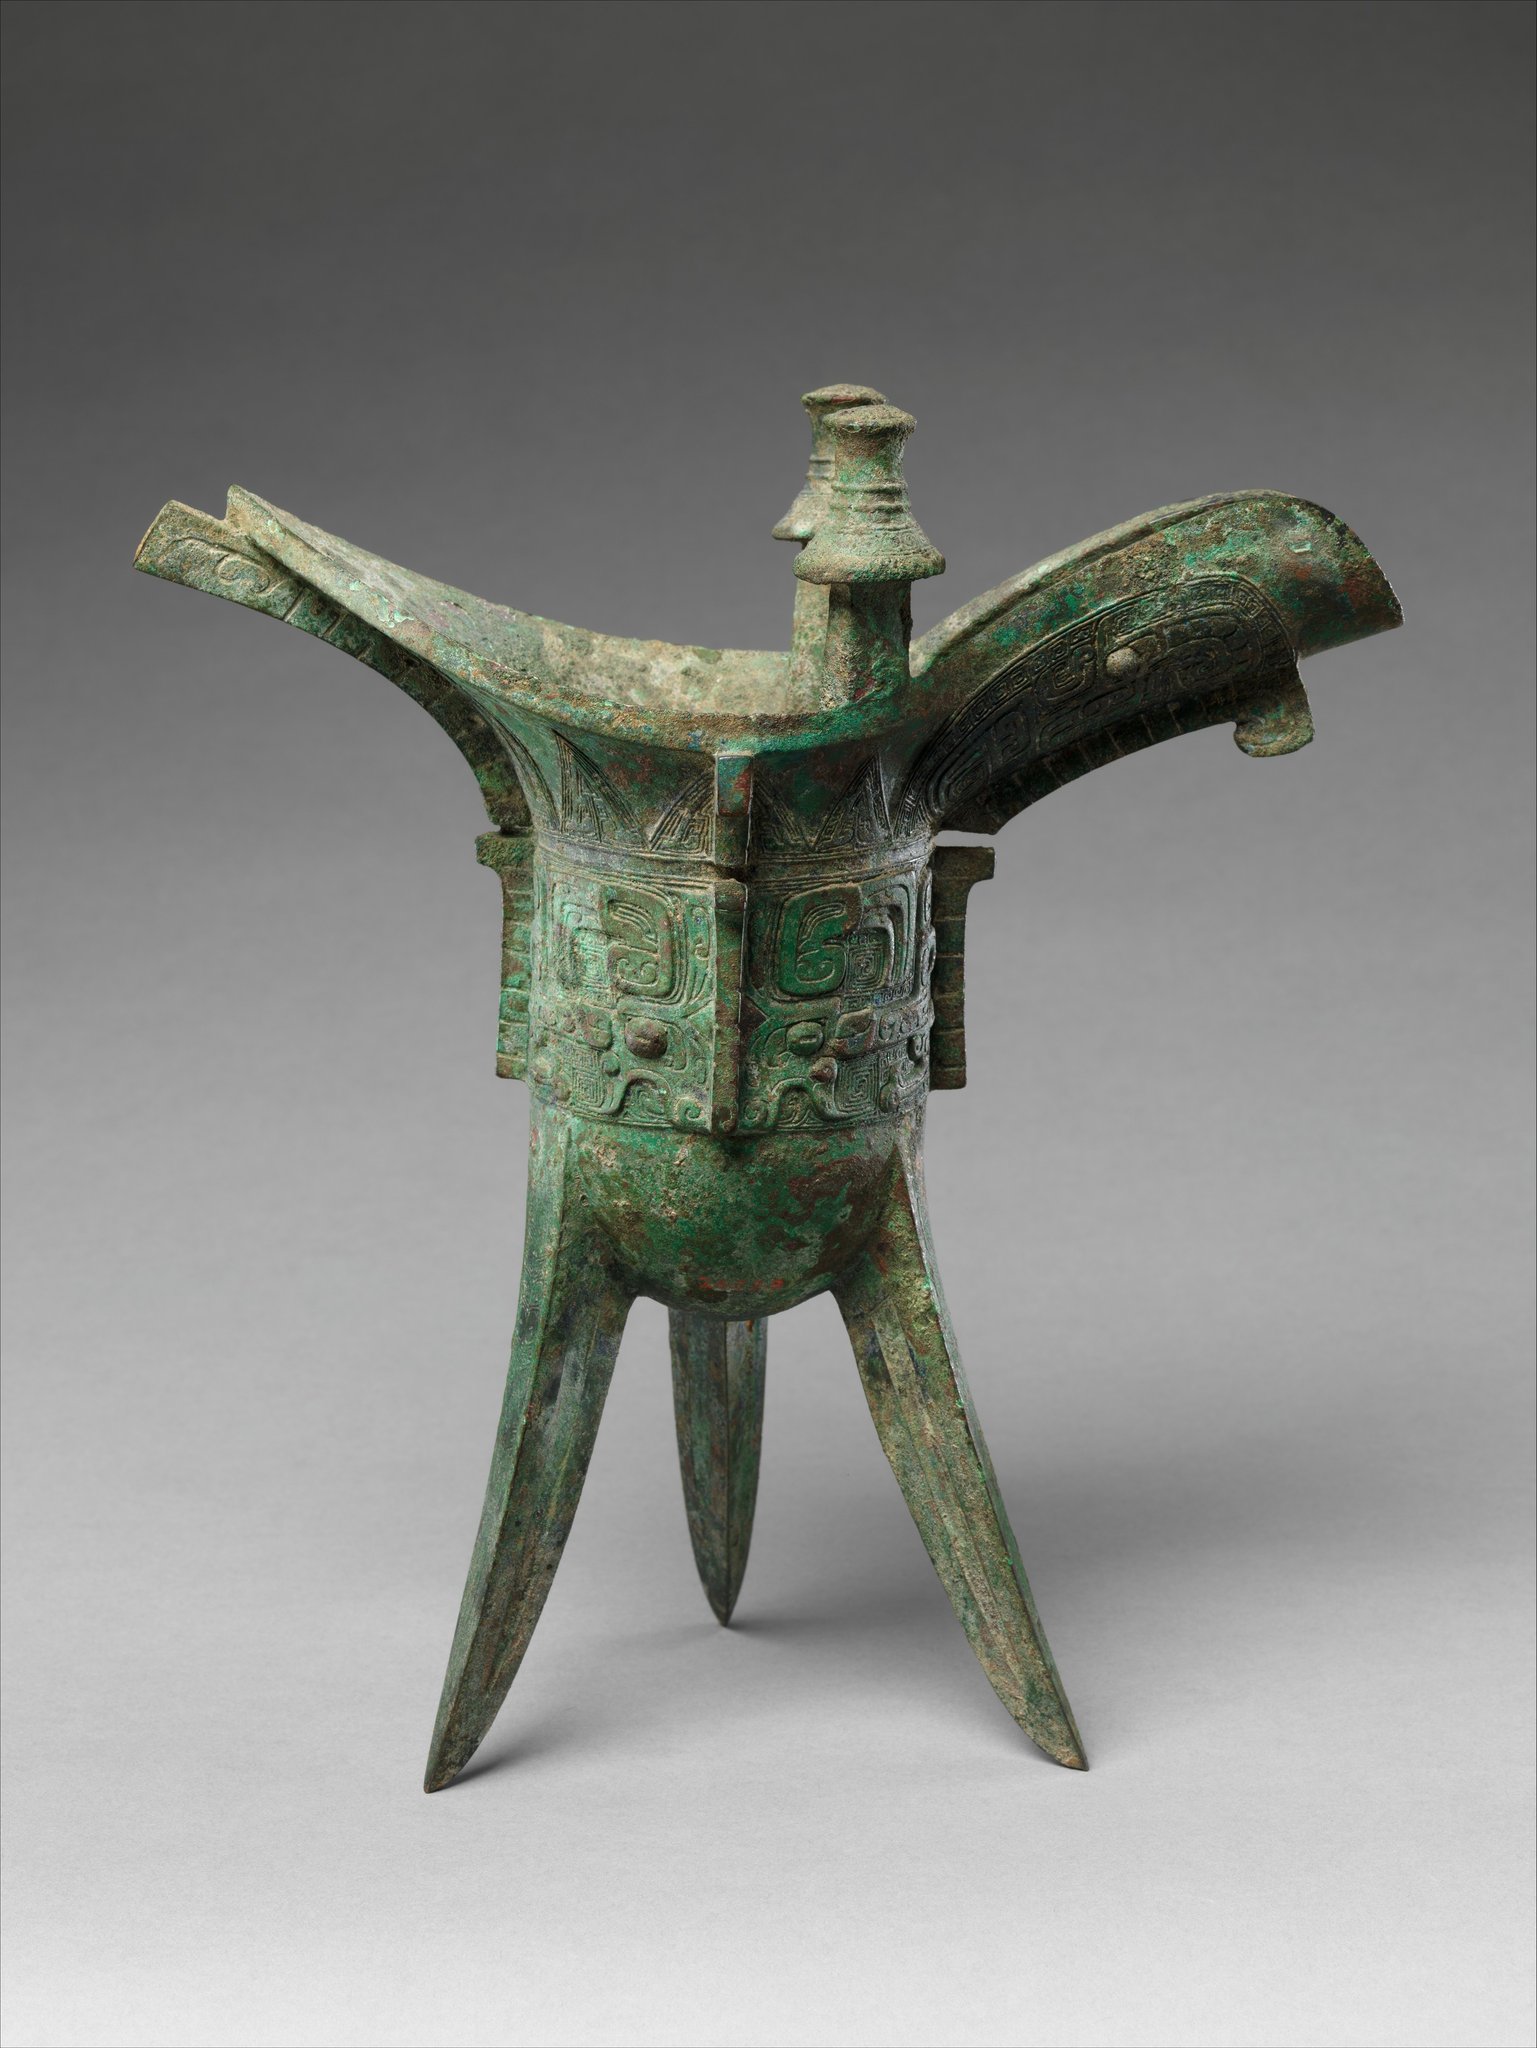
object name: wine vessel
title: Ritual Wine Vessel (Jue)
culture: chinese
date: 1034-1001 BCE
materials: bronze